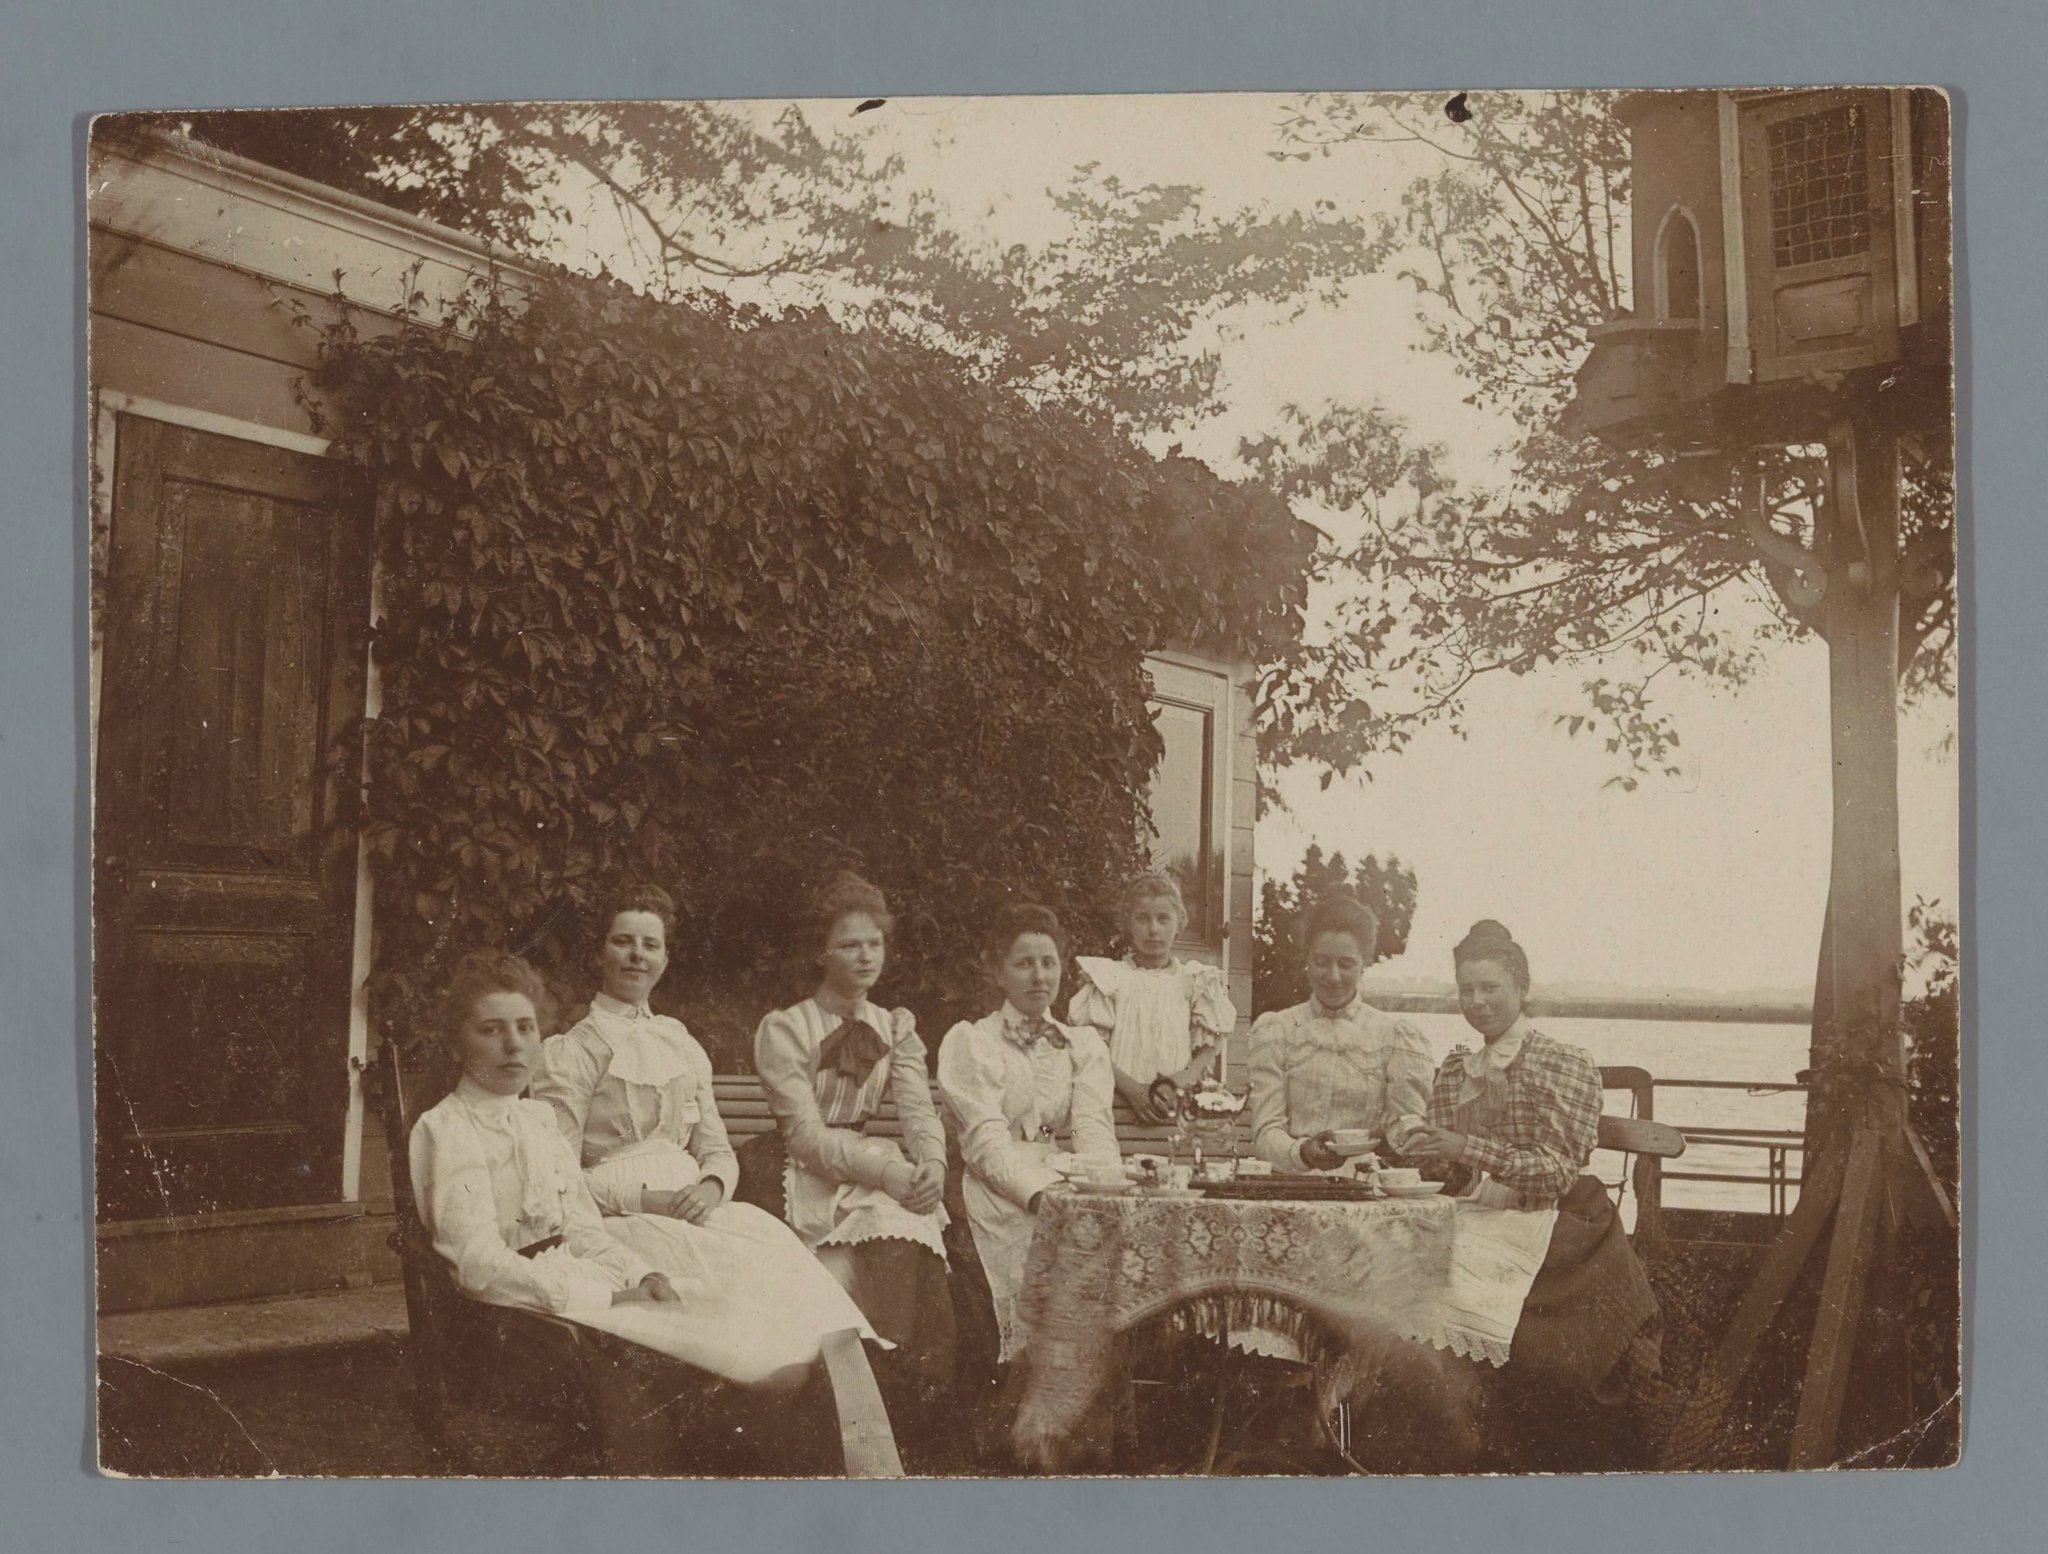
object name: photograph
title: Groepsportret van zeven onbekende vrouwen in een tuin langs het water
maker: Anonymous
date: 1900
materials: photographic support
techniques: gelatin silver print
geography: netherlands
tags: garden, anonymous historical persons portrayed in a group, in a group-portrait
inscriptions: inscription: ‘1900’, name: ‘Anna Honig’